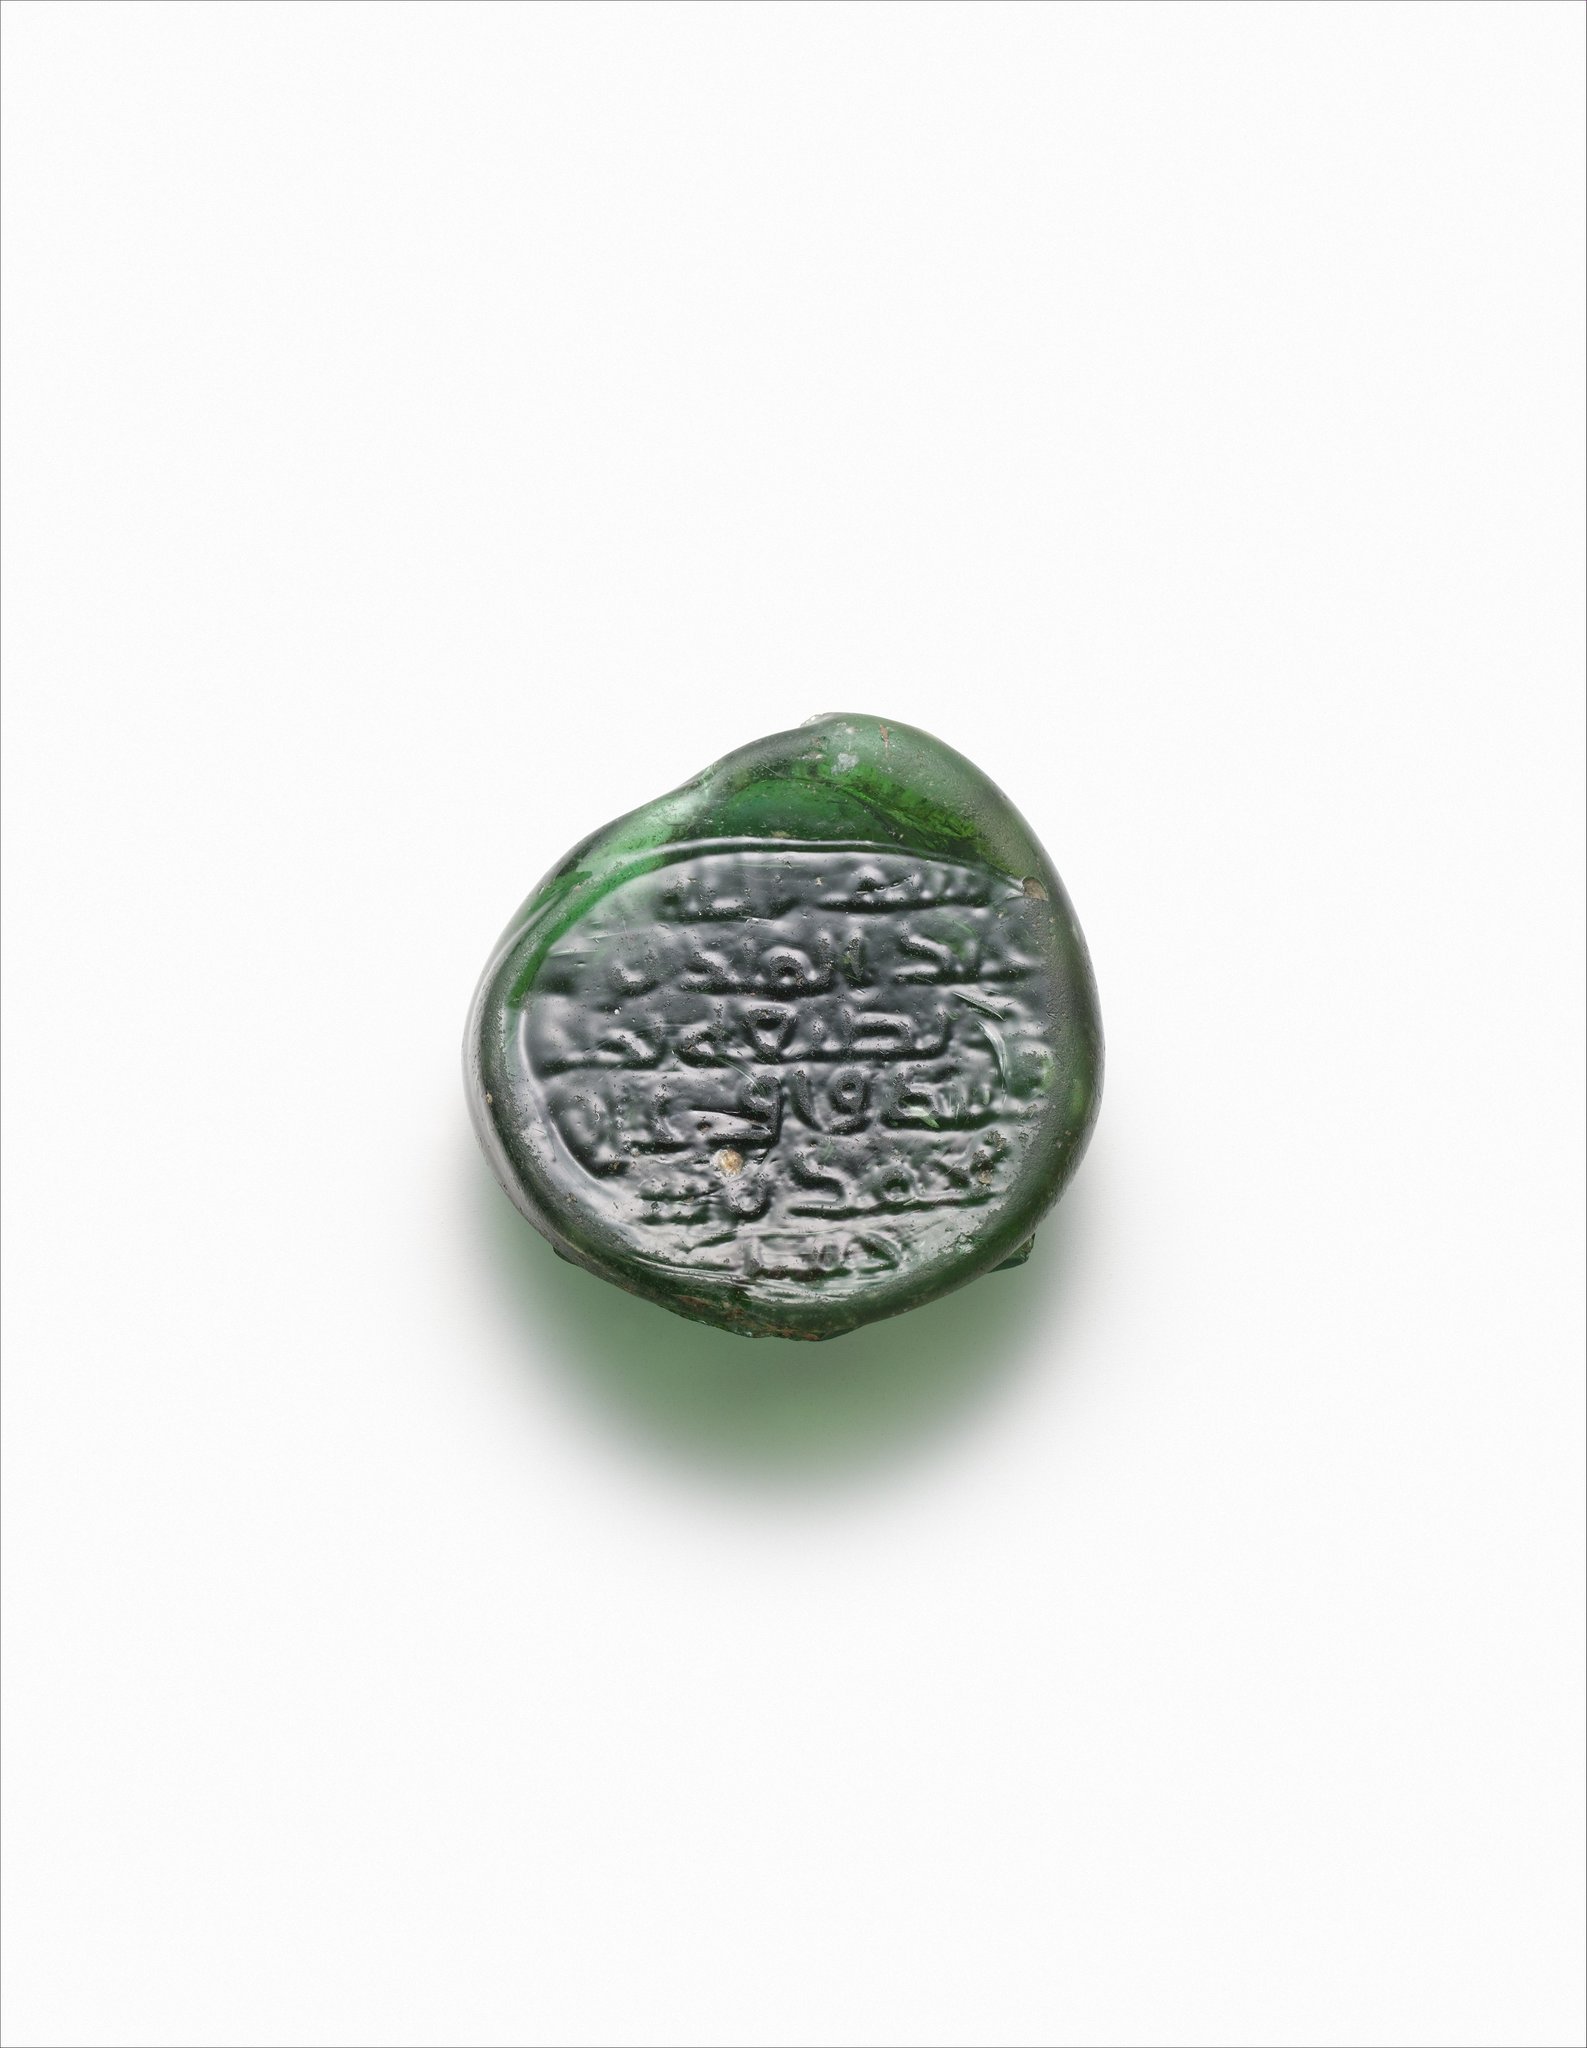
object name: vessel stamp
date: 751-758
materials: glass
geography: egypt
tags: arabic